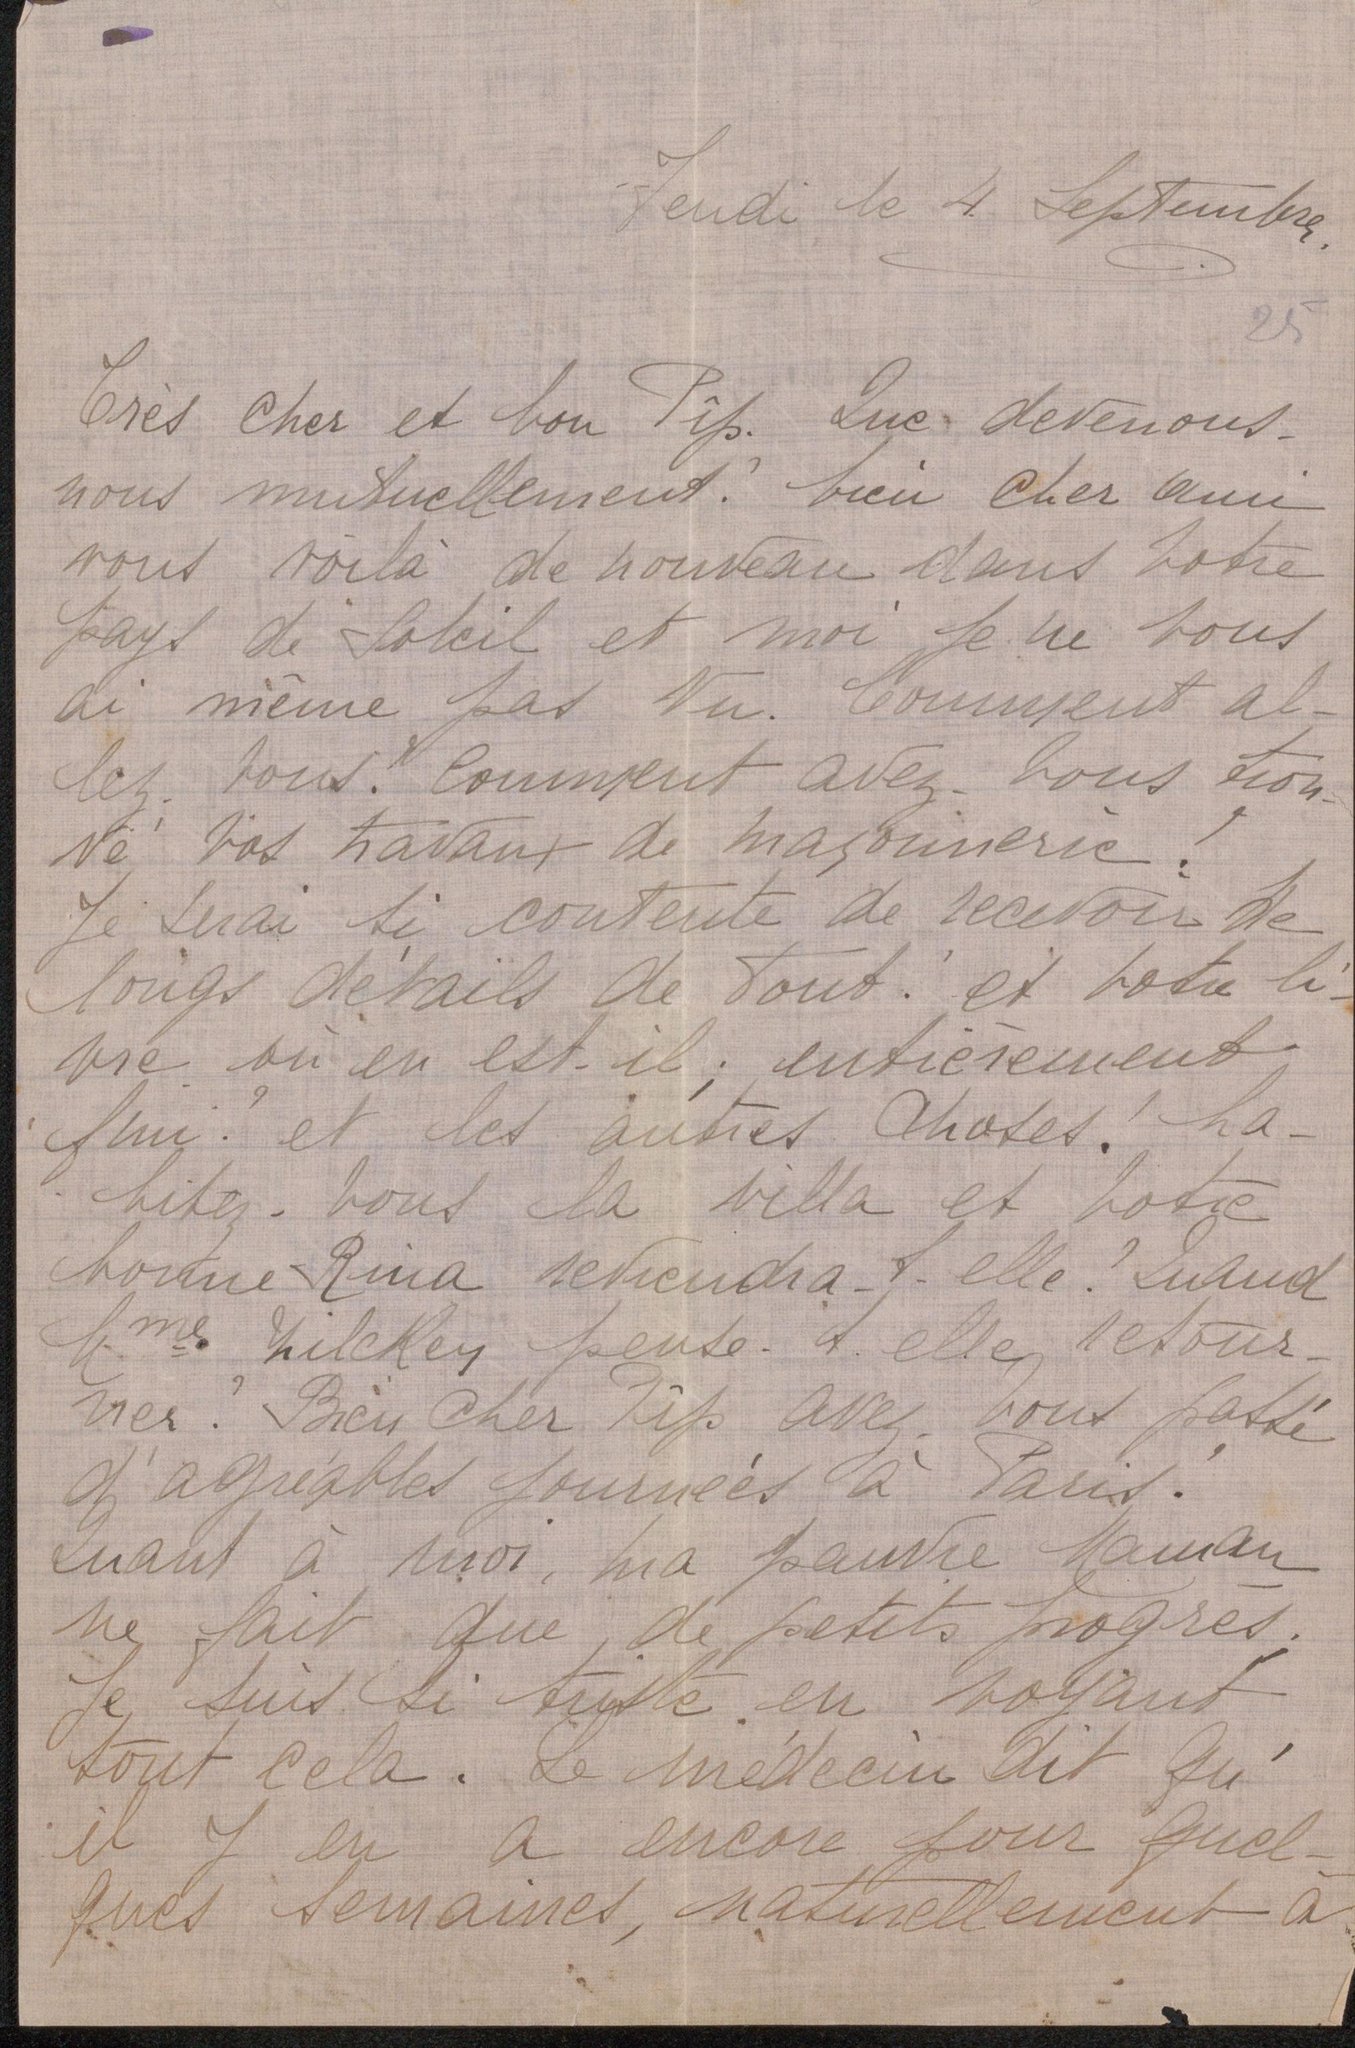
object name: letter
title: Brief aan Philip Zilcken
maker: rose imel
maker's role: draughtsman, painter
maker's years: 1901-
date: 1911-1930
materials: ink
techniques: pen, writing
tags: painter, draughtsman, philip zilcken, workshop, studio of the artist (in general), paris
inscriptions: collector's mark: ‘RPK’